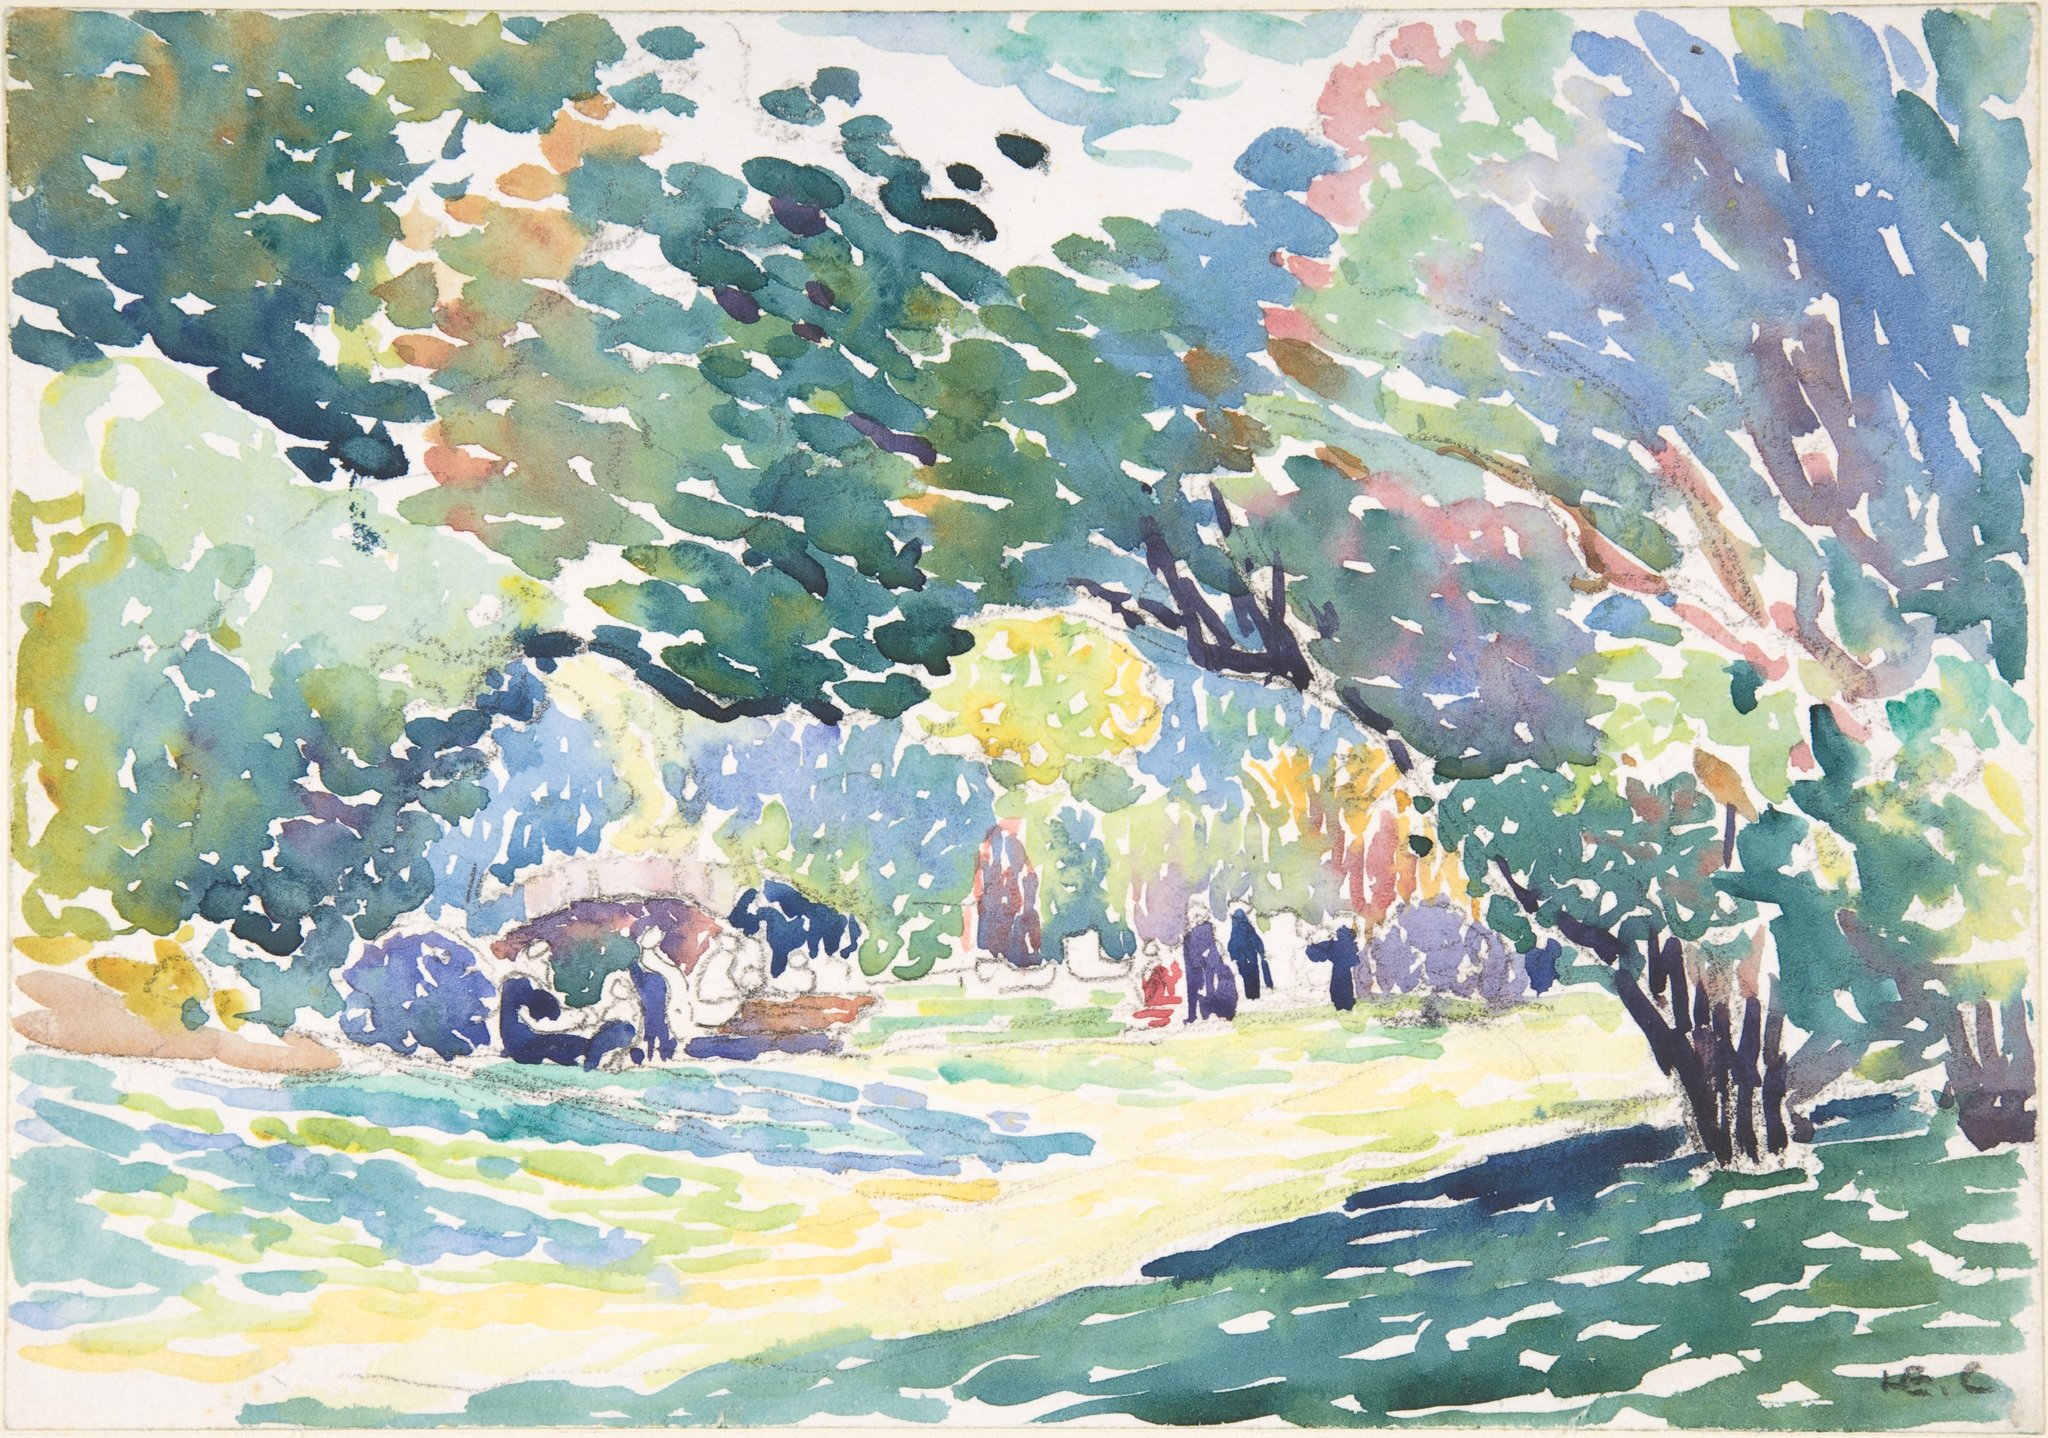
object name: drawing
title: Landscape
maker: henri-edmond cross (henri-edmond delacroix)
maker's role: artist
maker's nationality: french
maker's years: 1856-1910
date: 1904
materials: crayon, paper, watercolor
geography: france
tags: landscapes